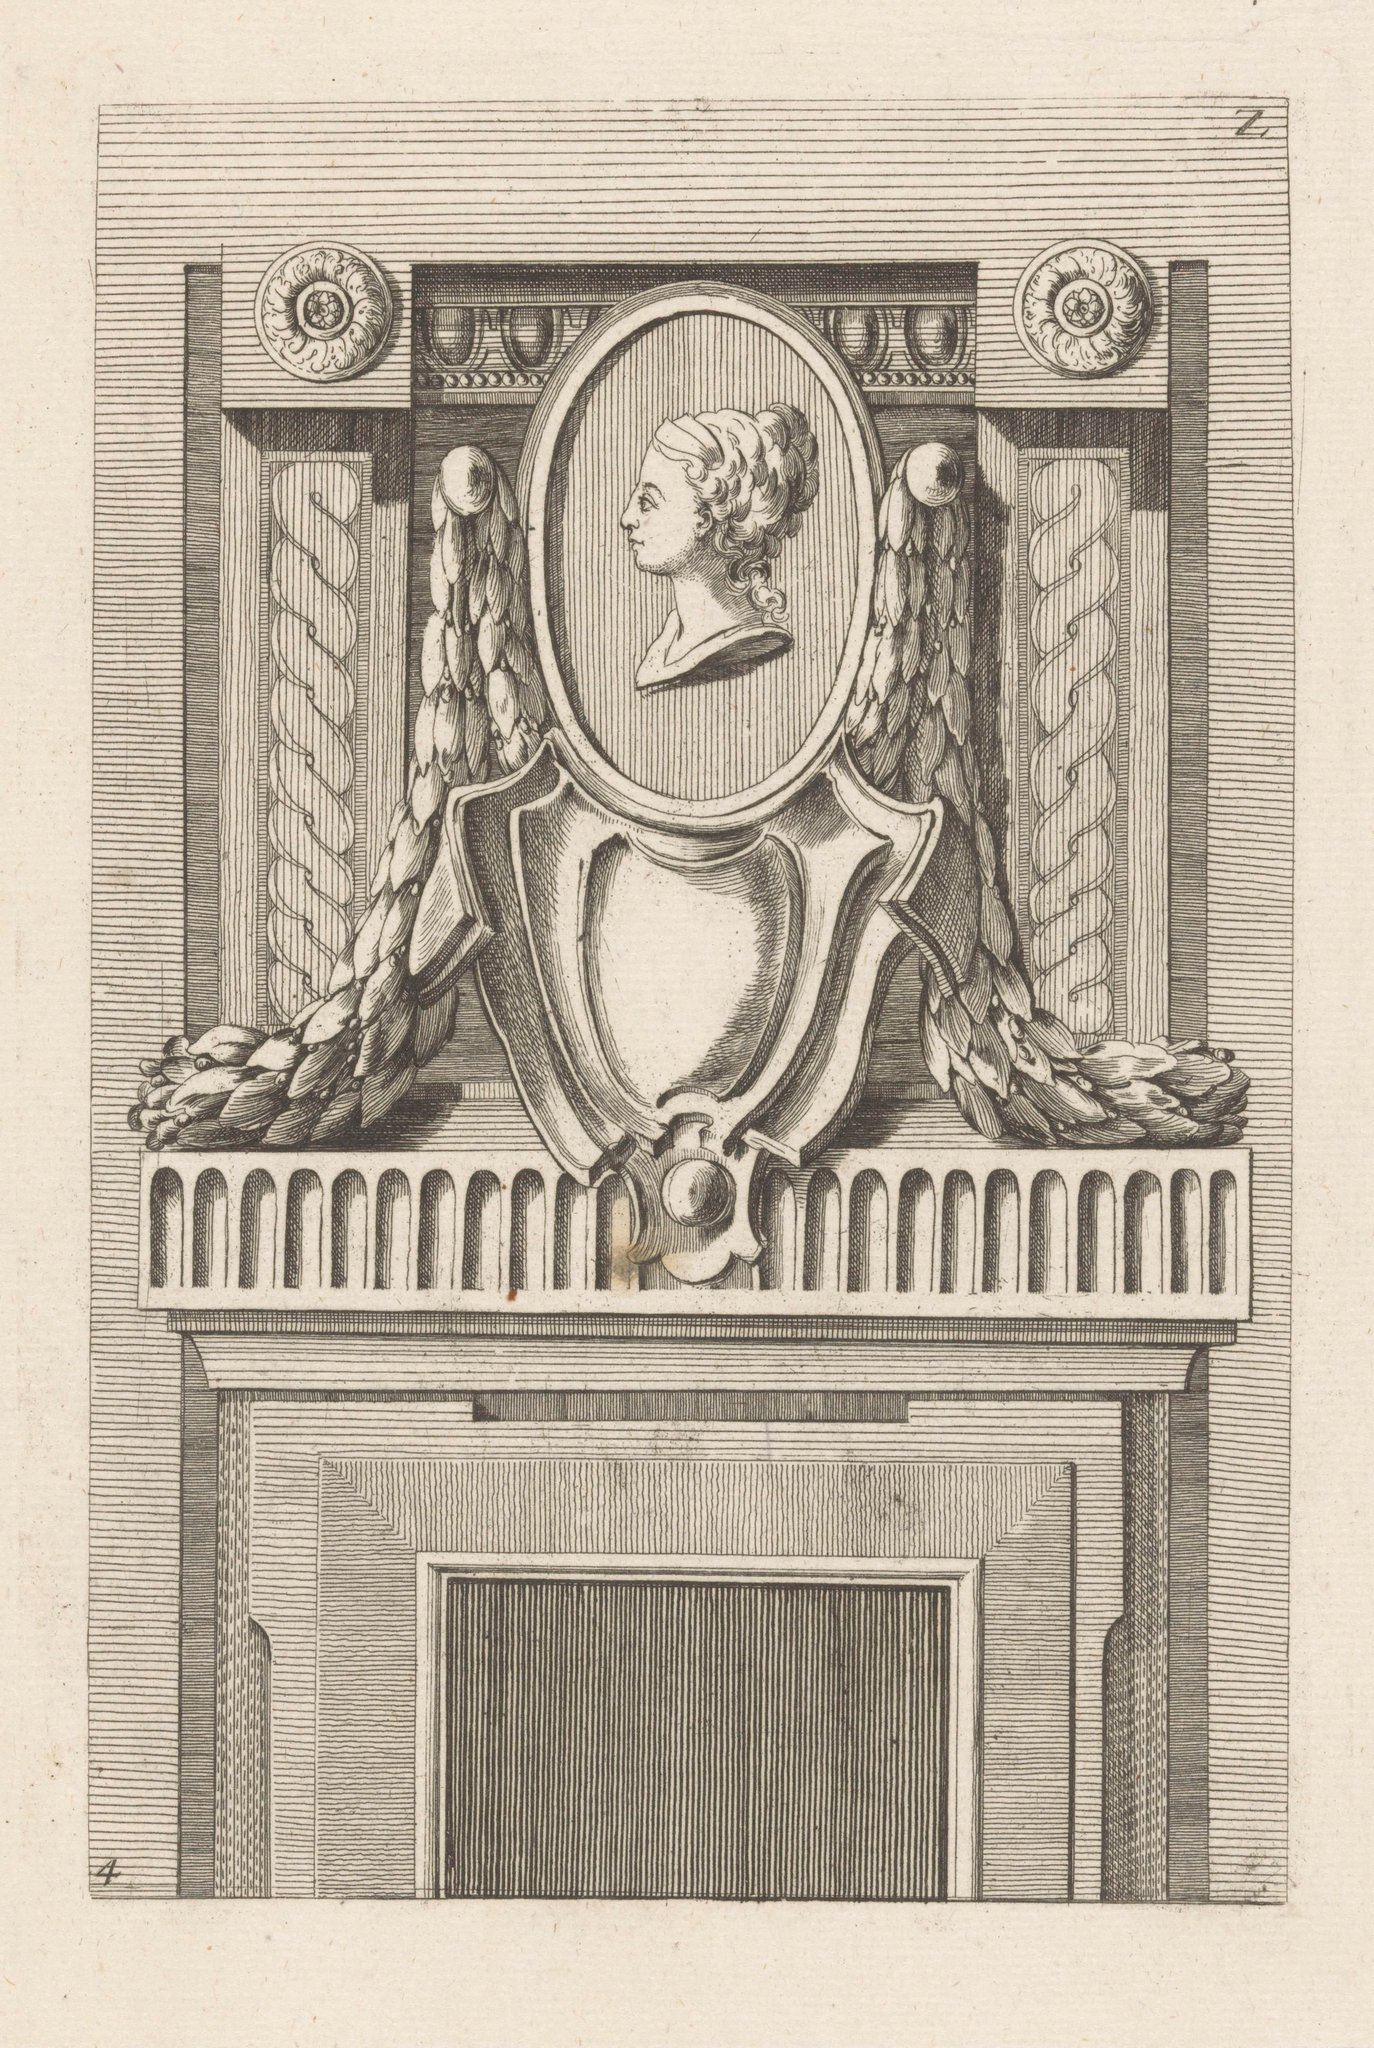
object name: ornament print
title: Dessus-de-porte met medaillon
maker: Anonymous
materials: paper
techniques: etching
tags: other architectural details (console), ornament ~ medallion, ornament ~ festoon, garland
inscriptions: collector's mark: Lugt 2228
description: Een dessus-de-porte met cartouche, guirlandes en een ovaal medaillon met vrouwenportret en profil. Rechts boven Z genummerd. Links onder 4 genummerd.